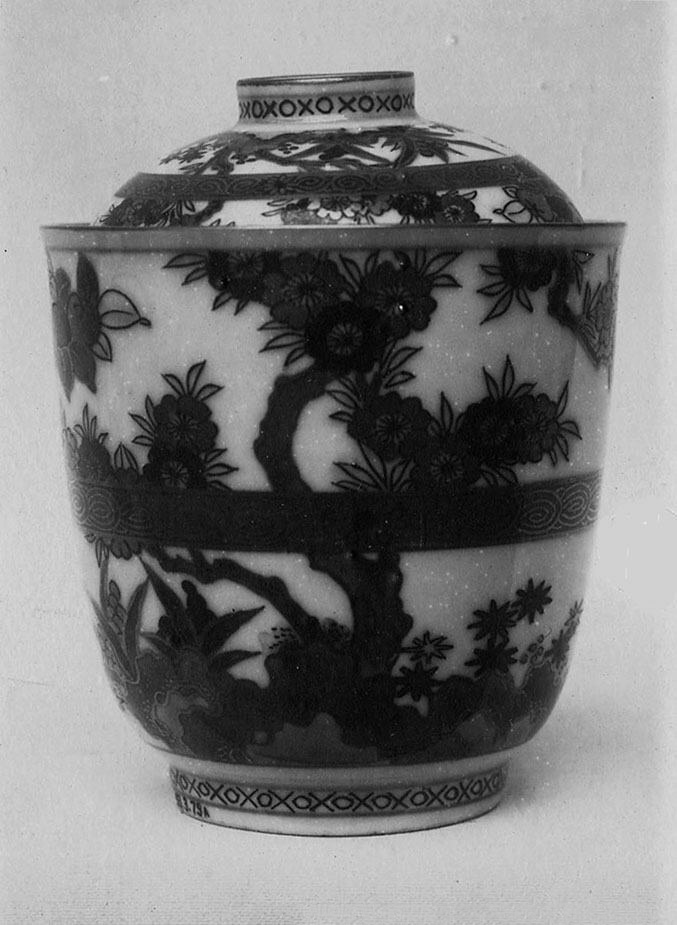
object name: cup with cover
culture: japanese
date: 1780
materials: enamel, glaze, porcelain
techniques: polychrome, relief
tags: trees